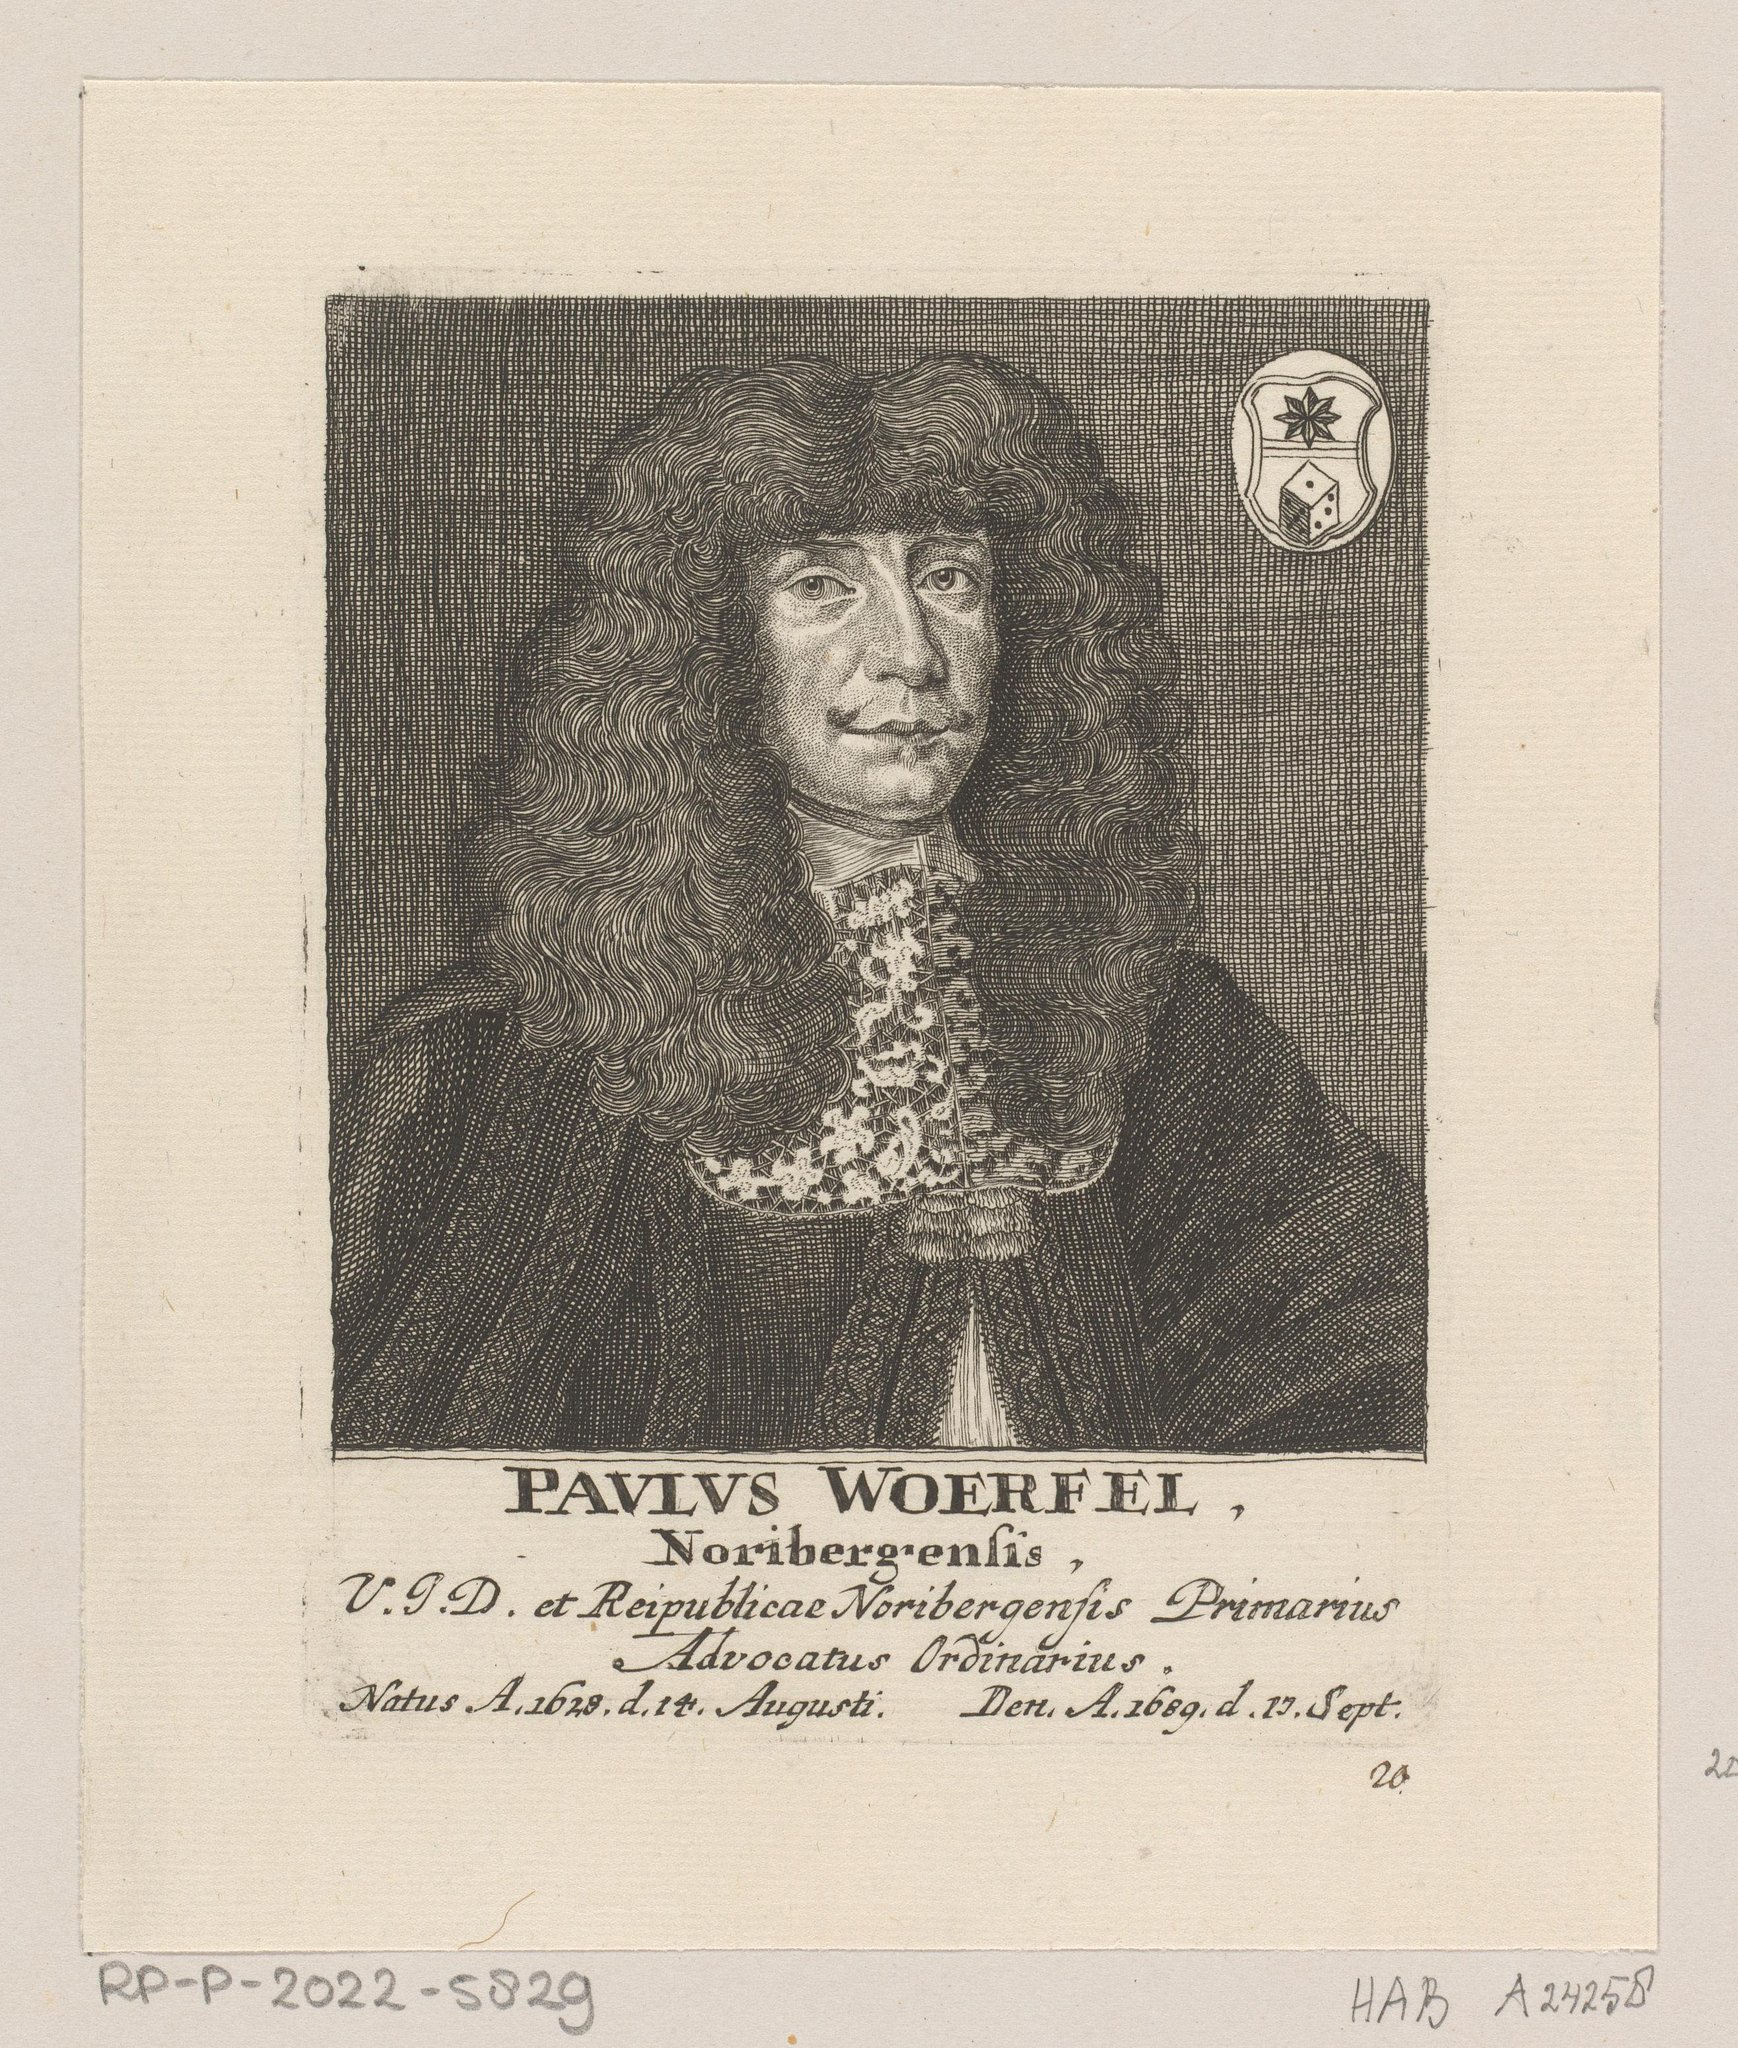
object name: book illustration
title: Portret van Paul Wörfel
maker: Anonymous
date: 1725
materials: paper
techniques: etching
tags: historical persons, lawyer, attorney at law, armorial bearing, heraldry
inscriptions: number: ‘20’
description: Prent mogelijk uit: Rothscholtz, Friedrich. Icones virorum omnium ordinum eruditione: omnique item genere et varietate artium de republica litteraria et speciatim de Academiis et Gymnasiis (...). Neurenberg: erven Johann Daniel Tauber, 1725. Of uit een andere serie van Rothscholtz.